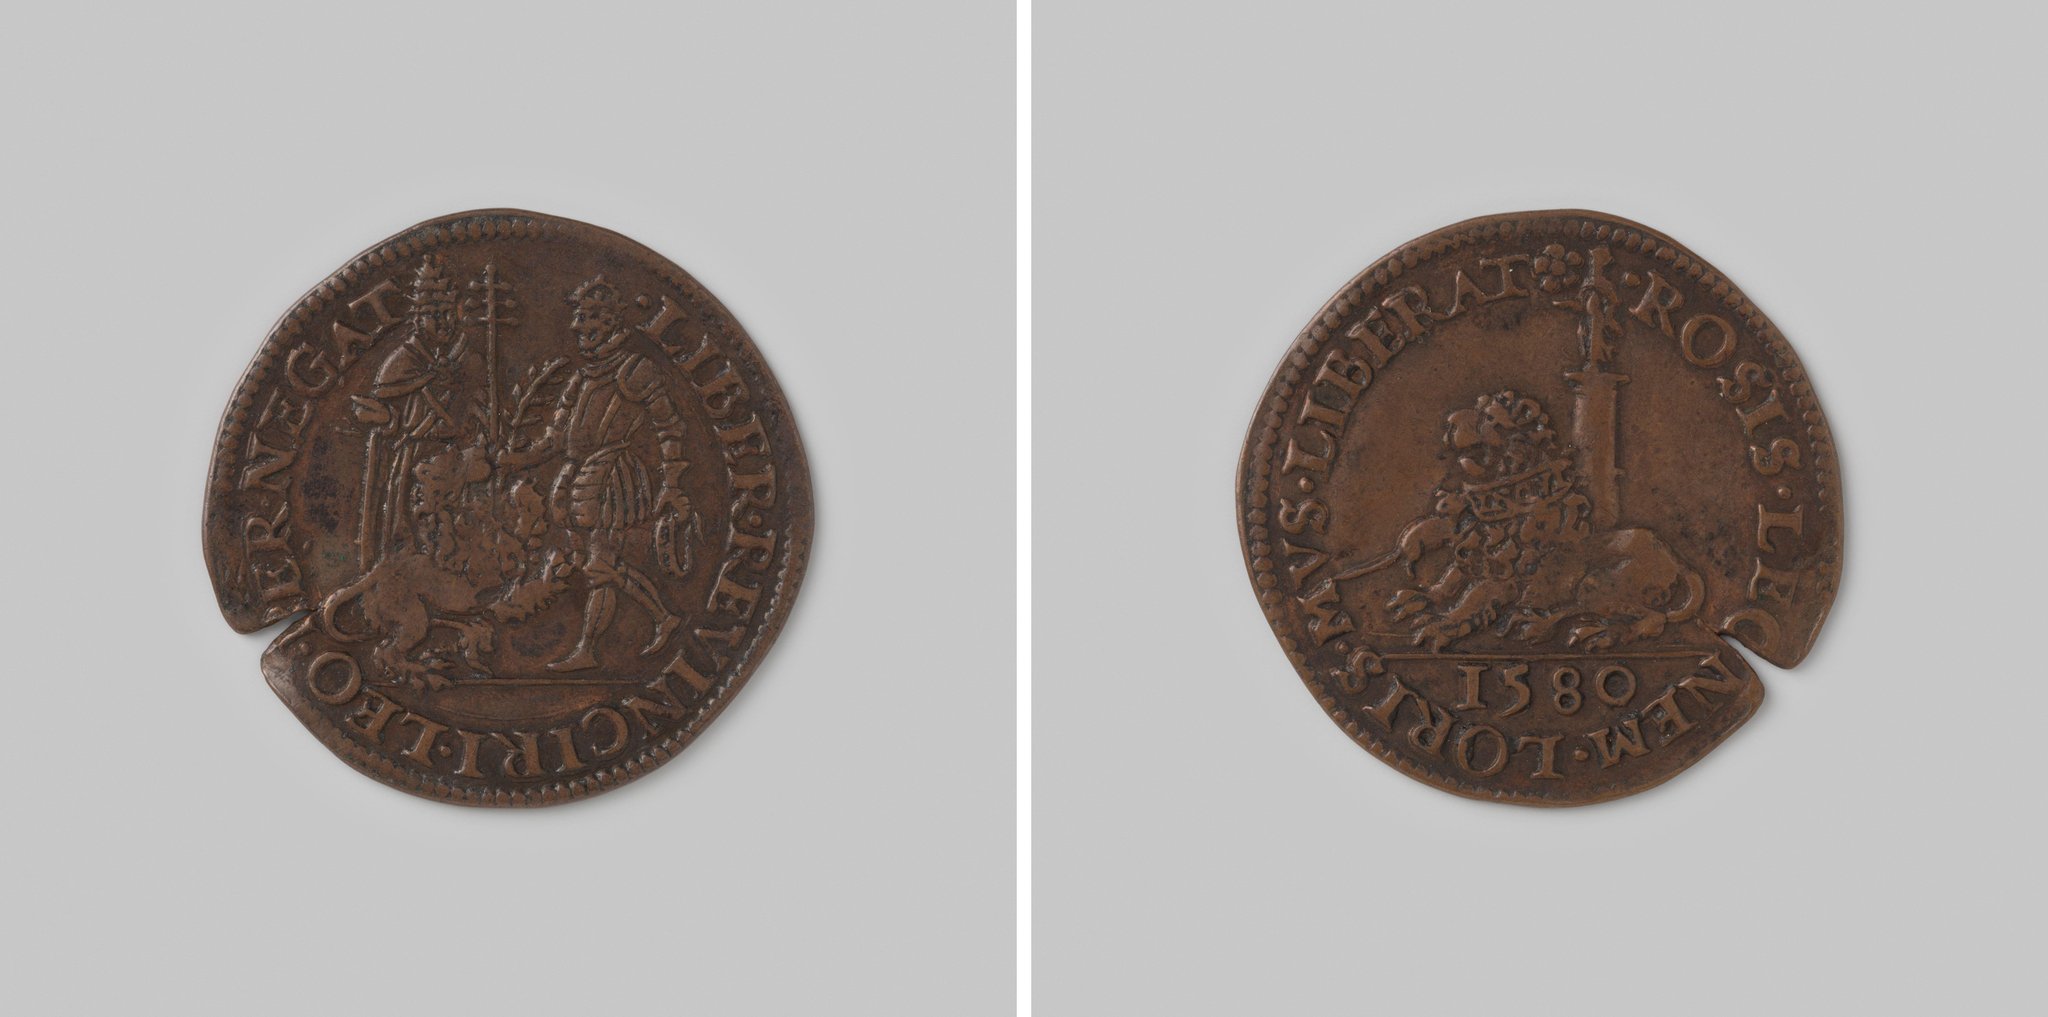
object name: jeton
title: Rekenpenning uit Dordrecht op de afgebroken vredesonderhandelingen te Keulen 1580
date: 1580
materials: copper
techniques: striking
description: Koperen penning, op de voorzijde de Spaanse Koning die een leeuw een olijftak aanbiedt maar een halsband achter zijn rug houdt, gezegend door de Paus, met omschrift, op de keerzijde een leeuw gekluisterd aan een zuil met een halsband, waar een rat aan knaagt, met afsnedetekst en omschrift.